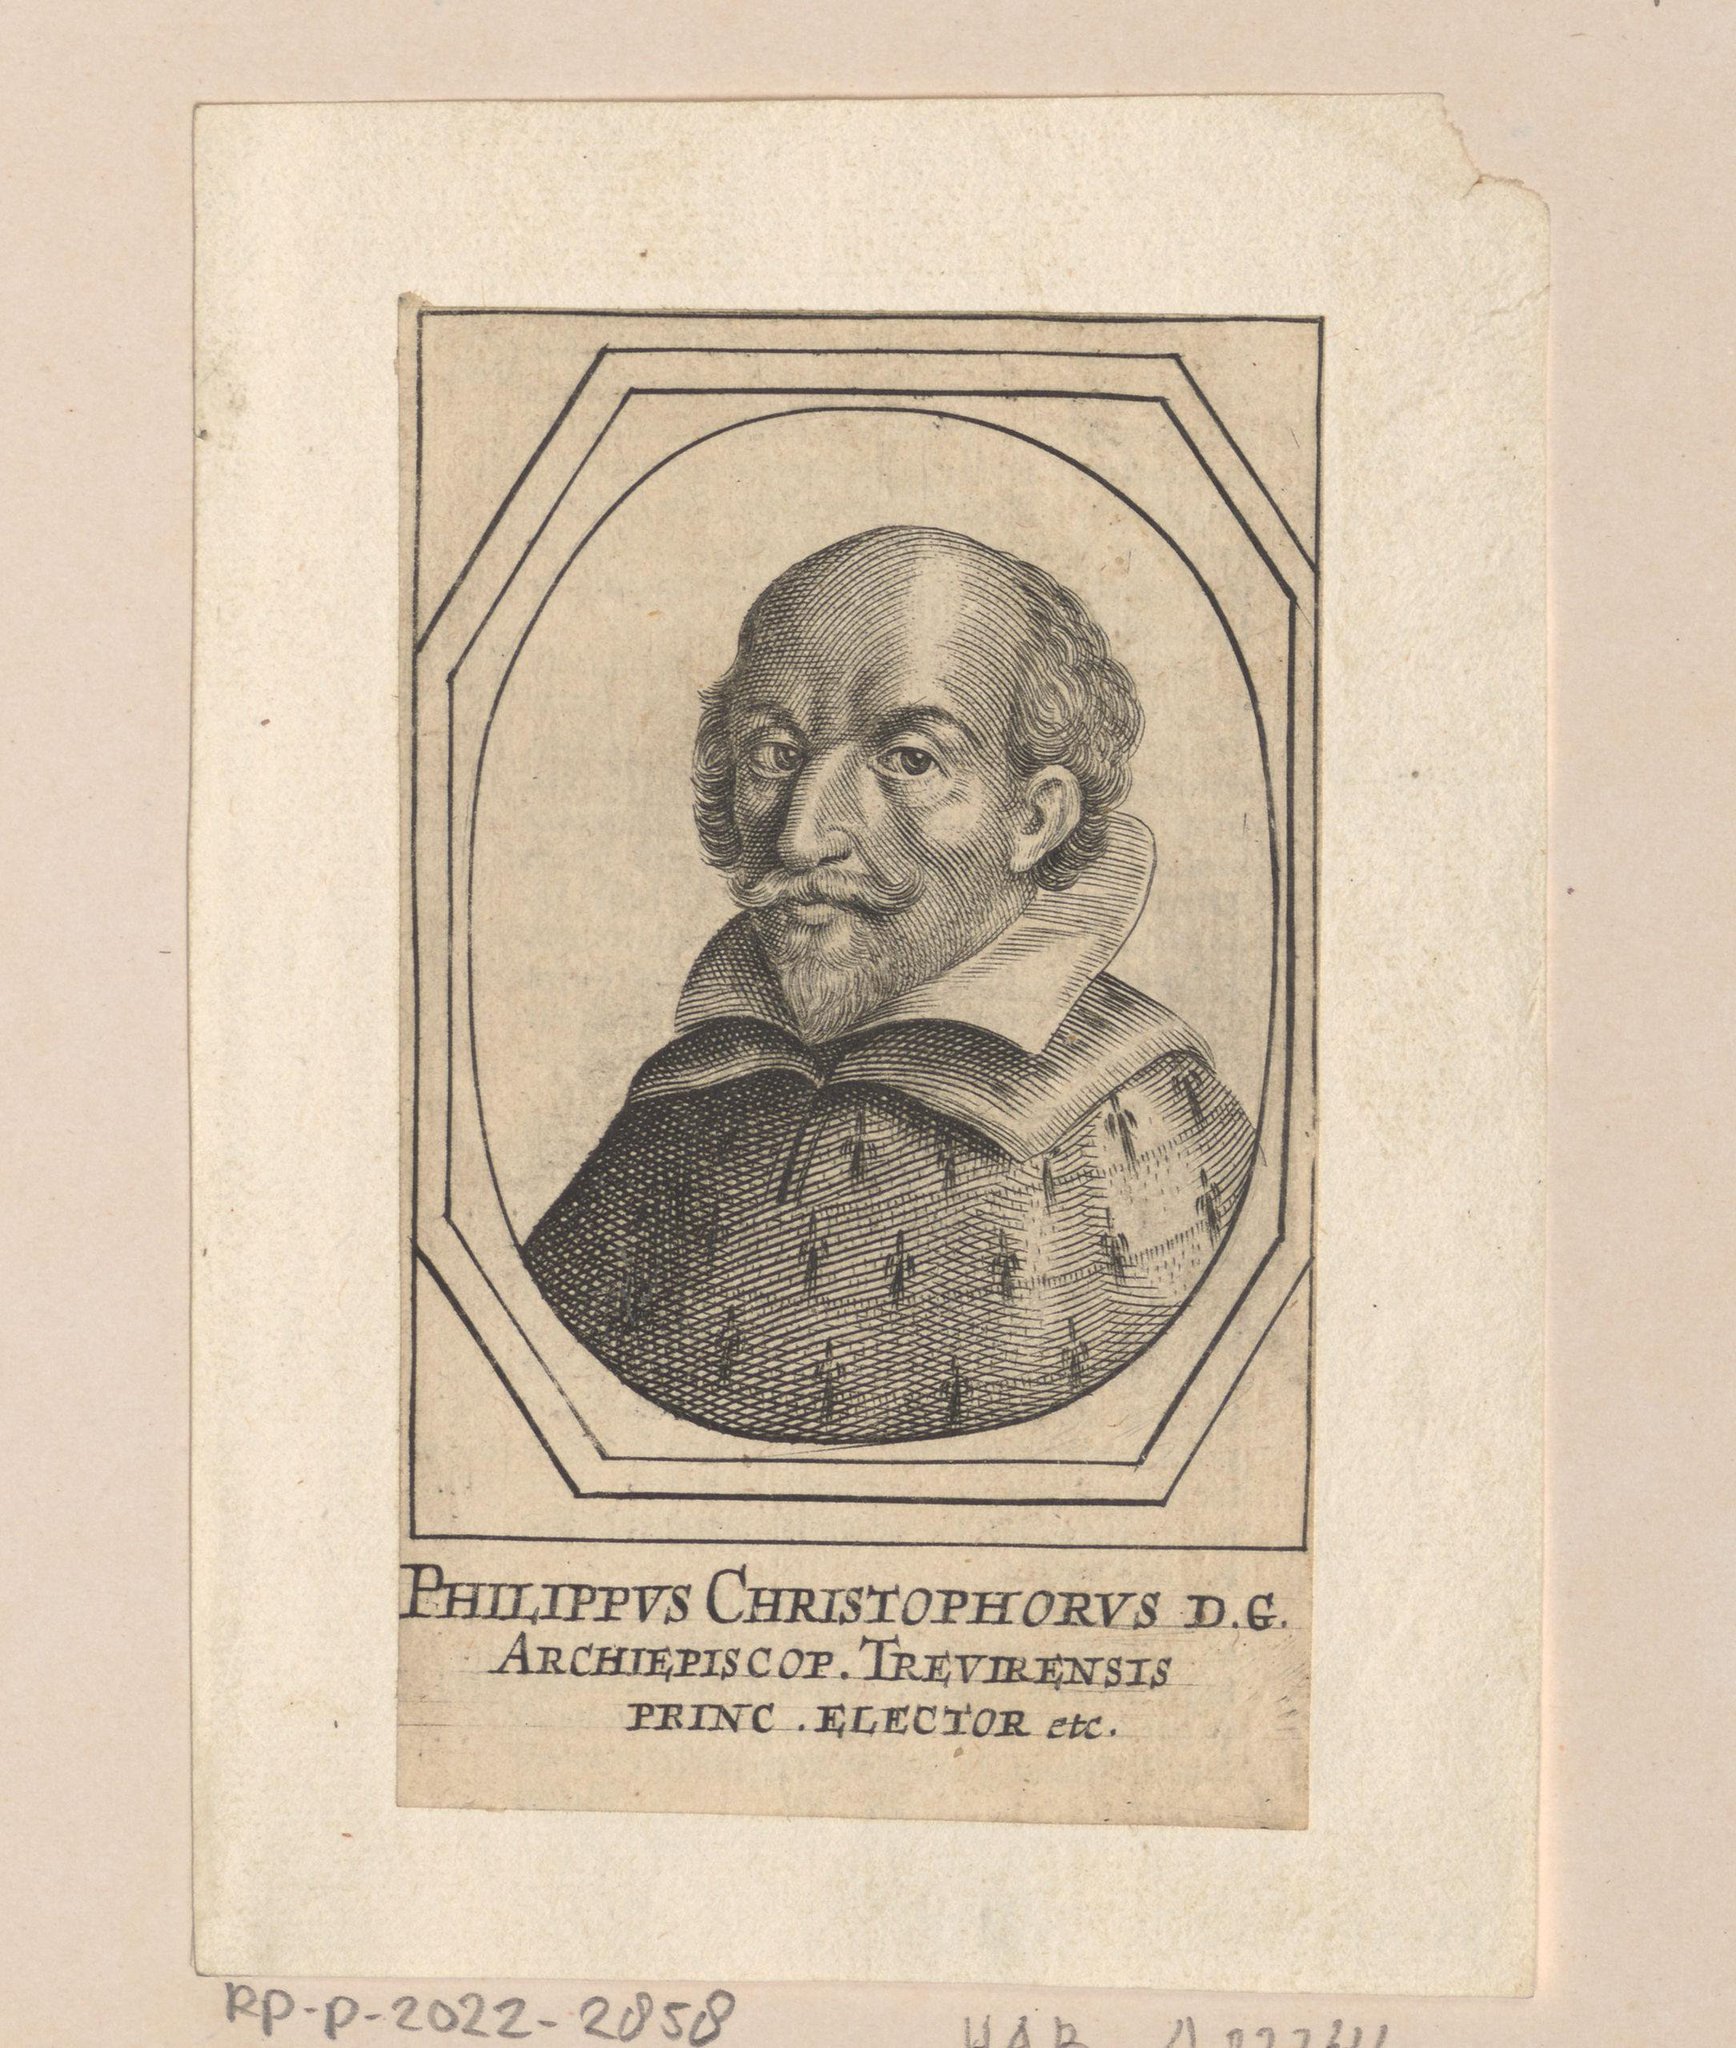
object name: print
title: Portret van Philipp Christoph von Sötern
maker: Anonymous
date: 1647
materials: paper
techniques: engraving, snipping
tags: archbishop, bishop, etc. (roman catholic), historical persons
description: Prent mogelijk uit: Wassenberg, Eberhard. Der Ernewerder, verbesserde vnd bis in Jahr 1647 continuirde Teutsche Floris. Frankfurt am Main: Anton Humm, 1647.